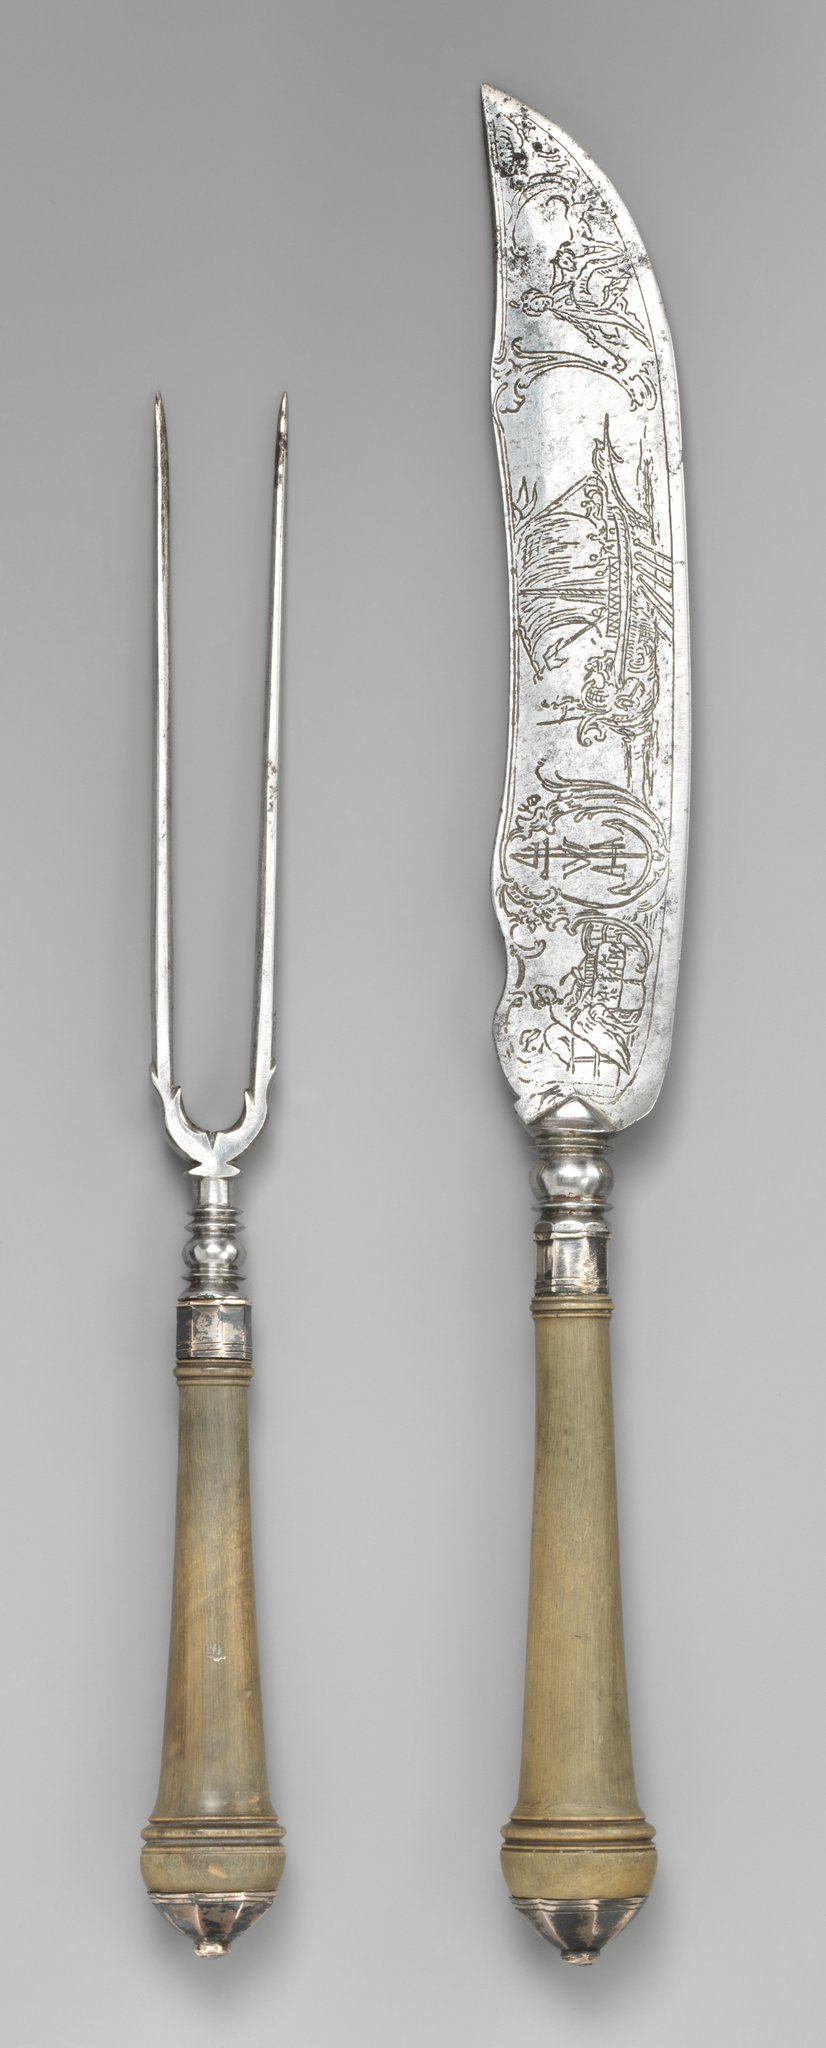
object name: fork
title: Carving fork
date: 1767-1800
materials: horn, silver, steel